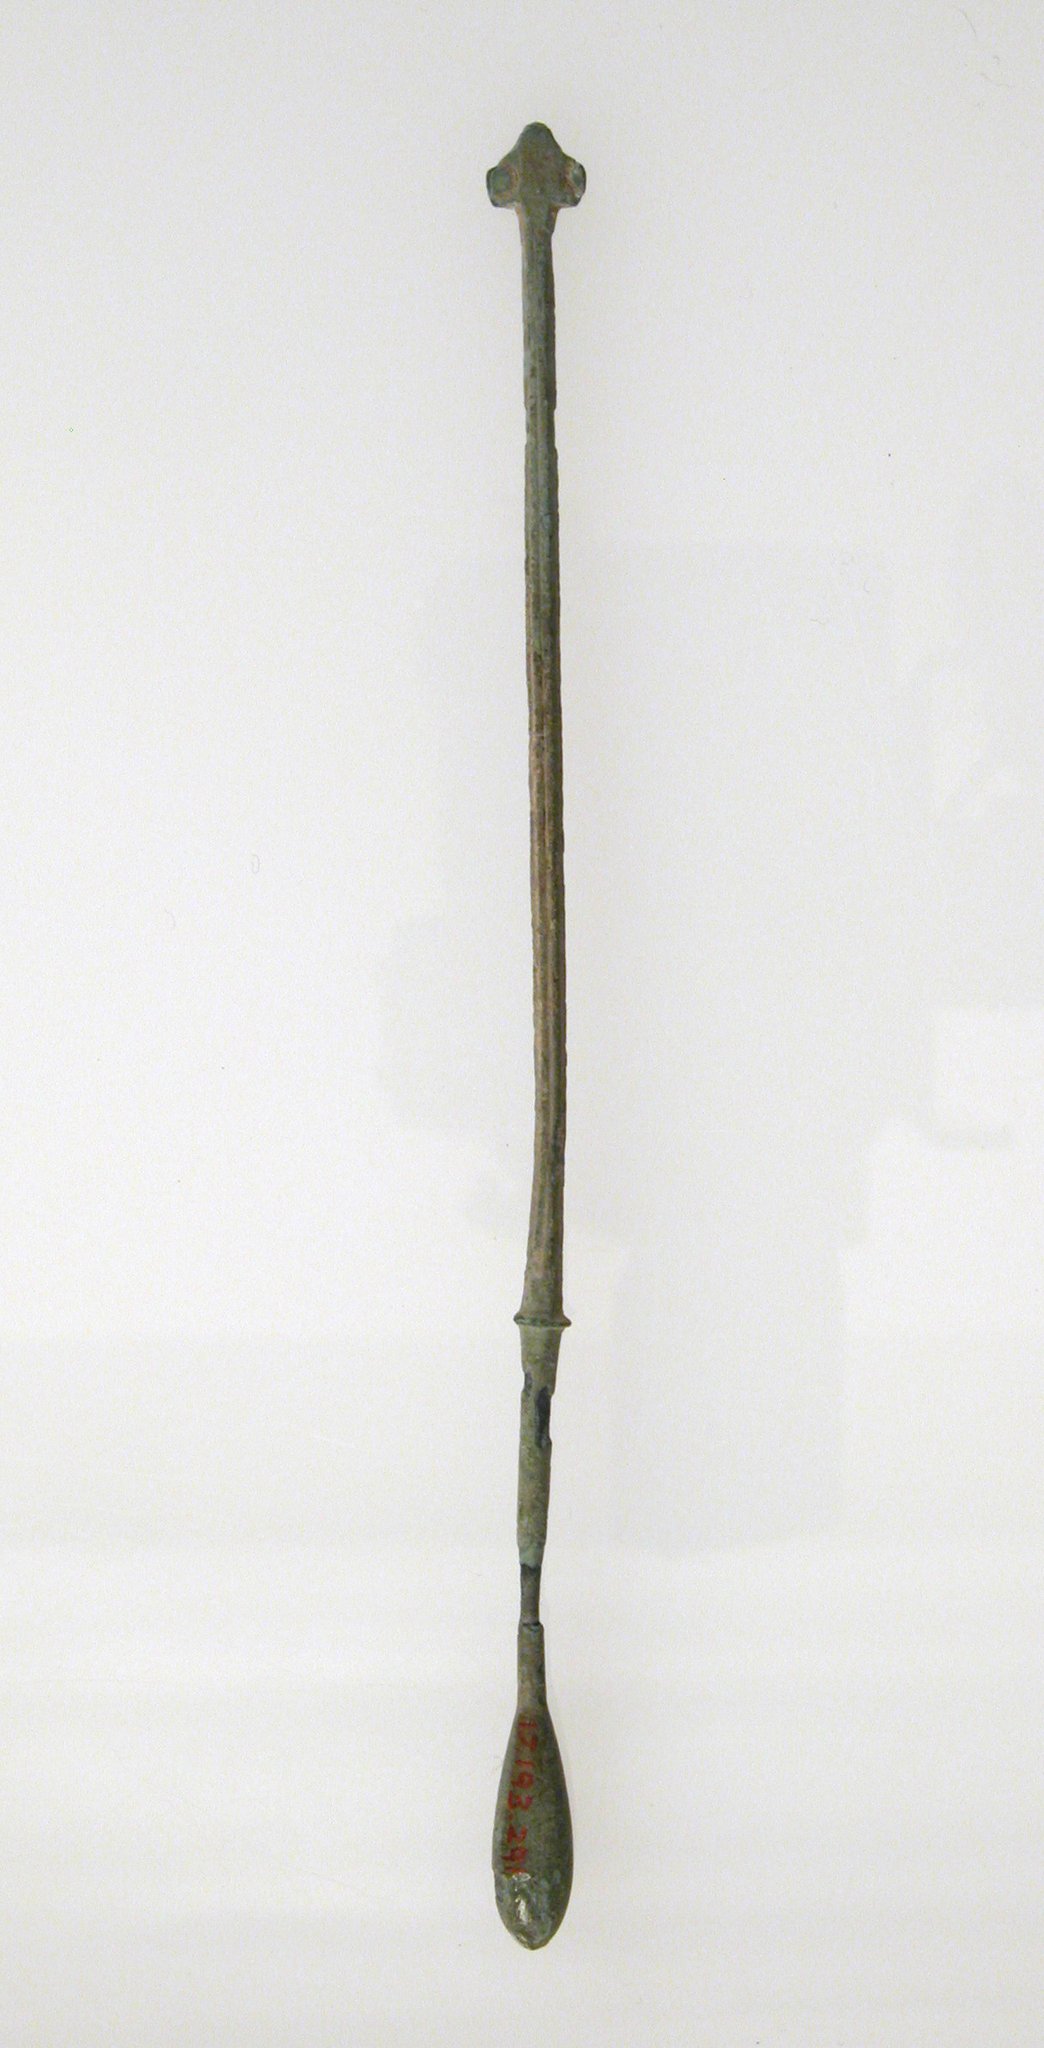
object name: hairpin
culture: frankish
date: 601-700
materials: bronze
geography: germany